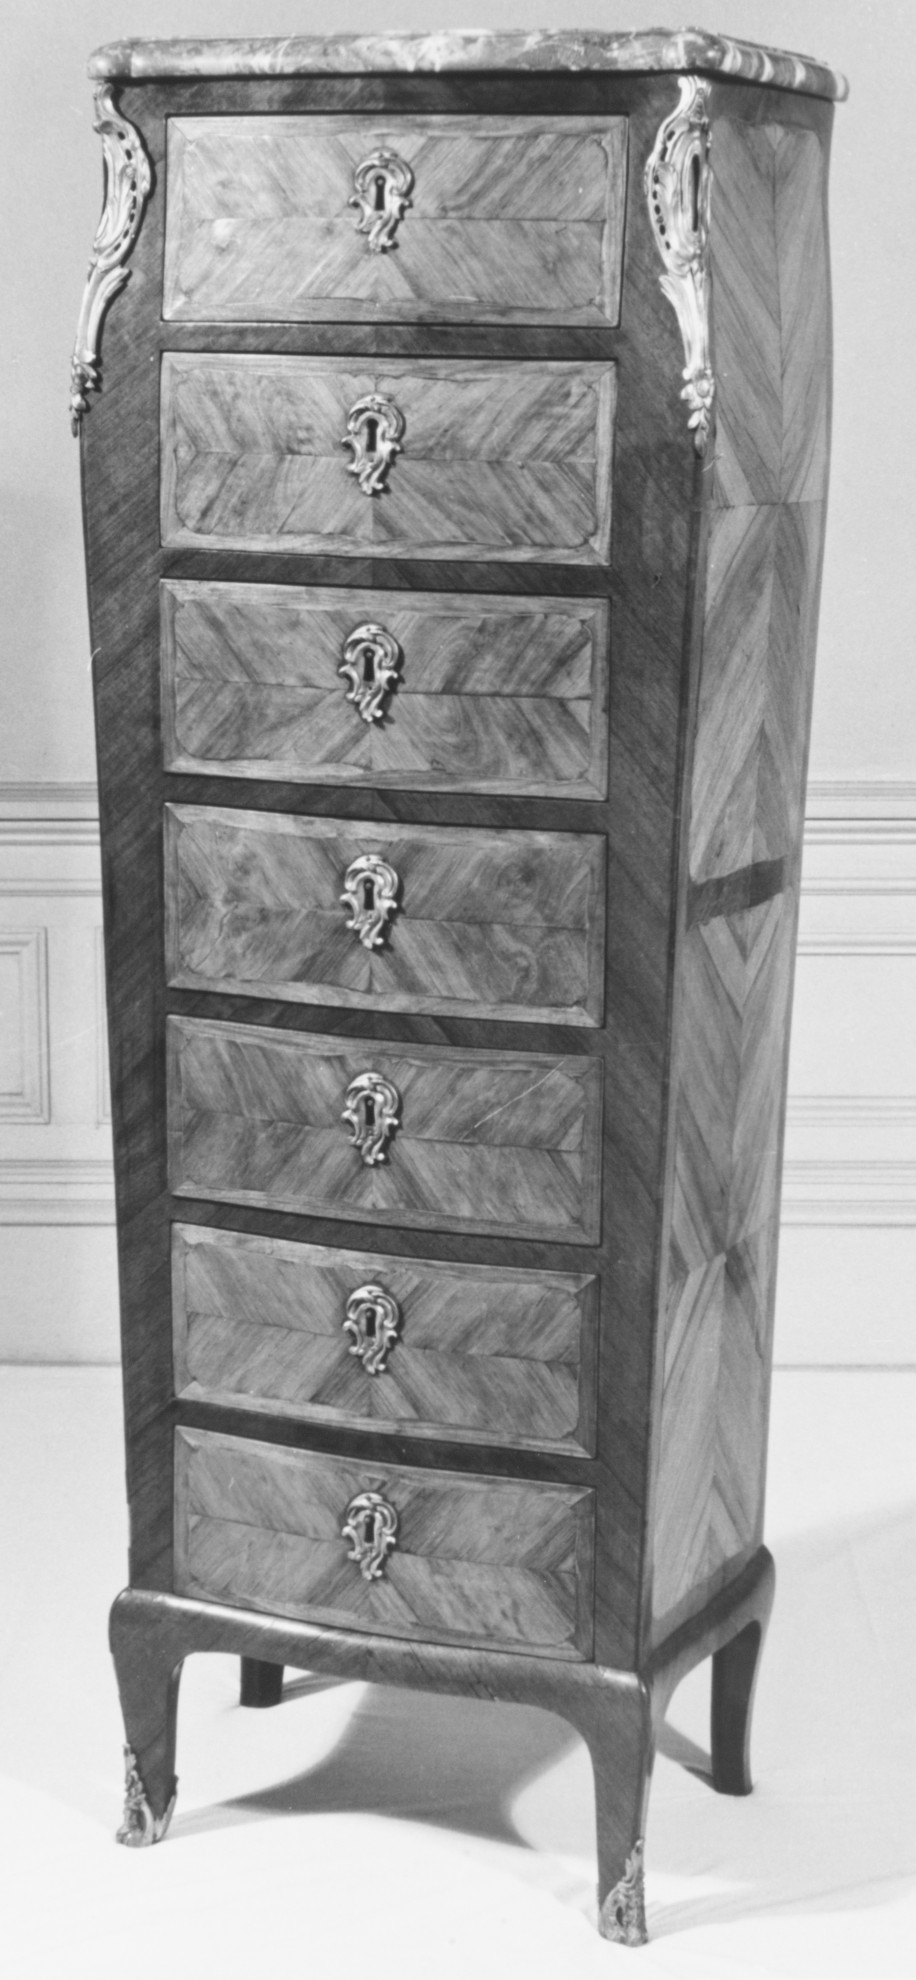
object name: chest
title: Chest (chiffonier) (one of a pair)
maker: bernard ii van risenburgh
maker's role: maker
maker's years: 1696-1767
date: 1765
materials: gilt bronze, marble, wood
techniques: veneering